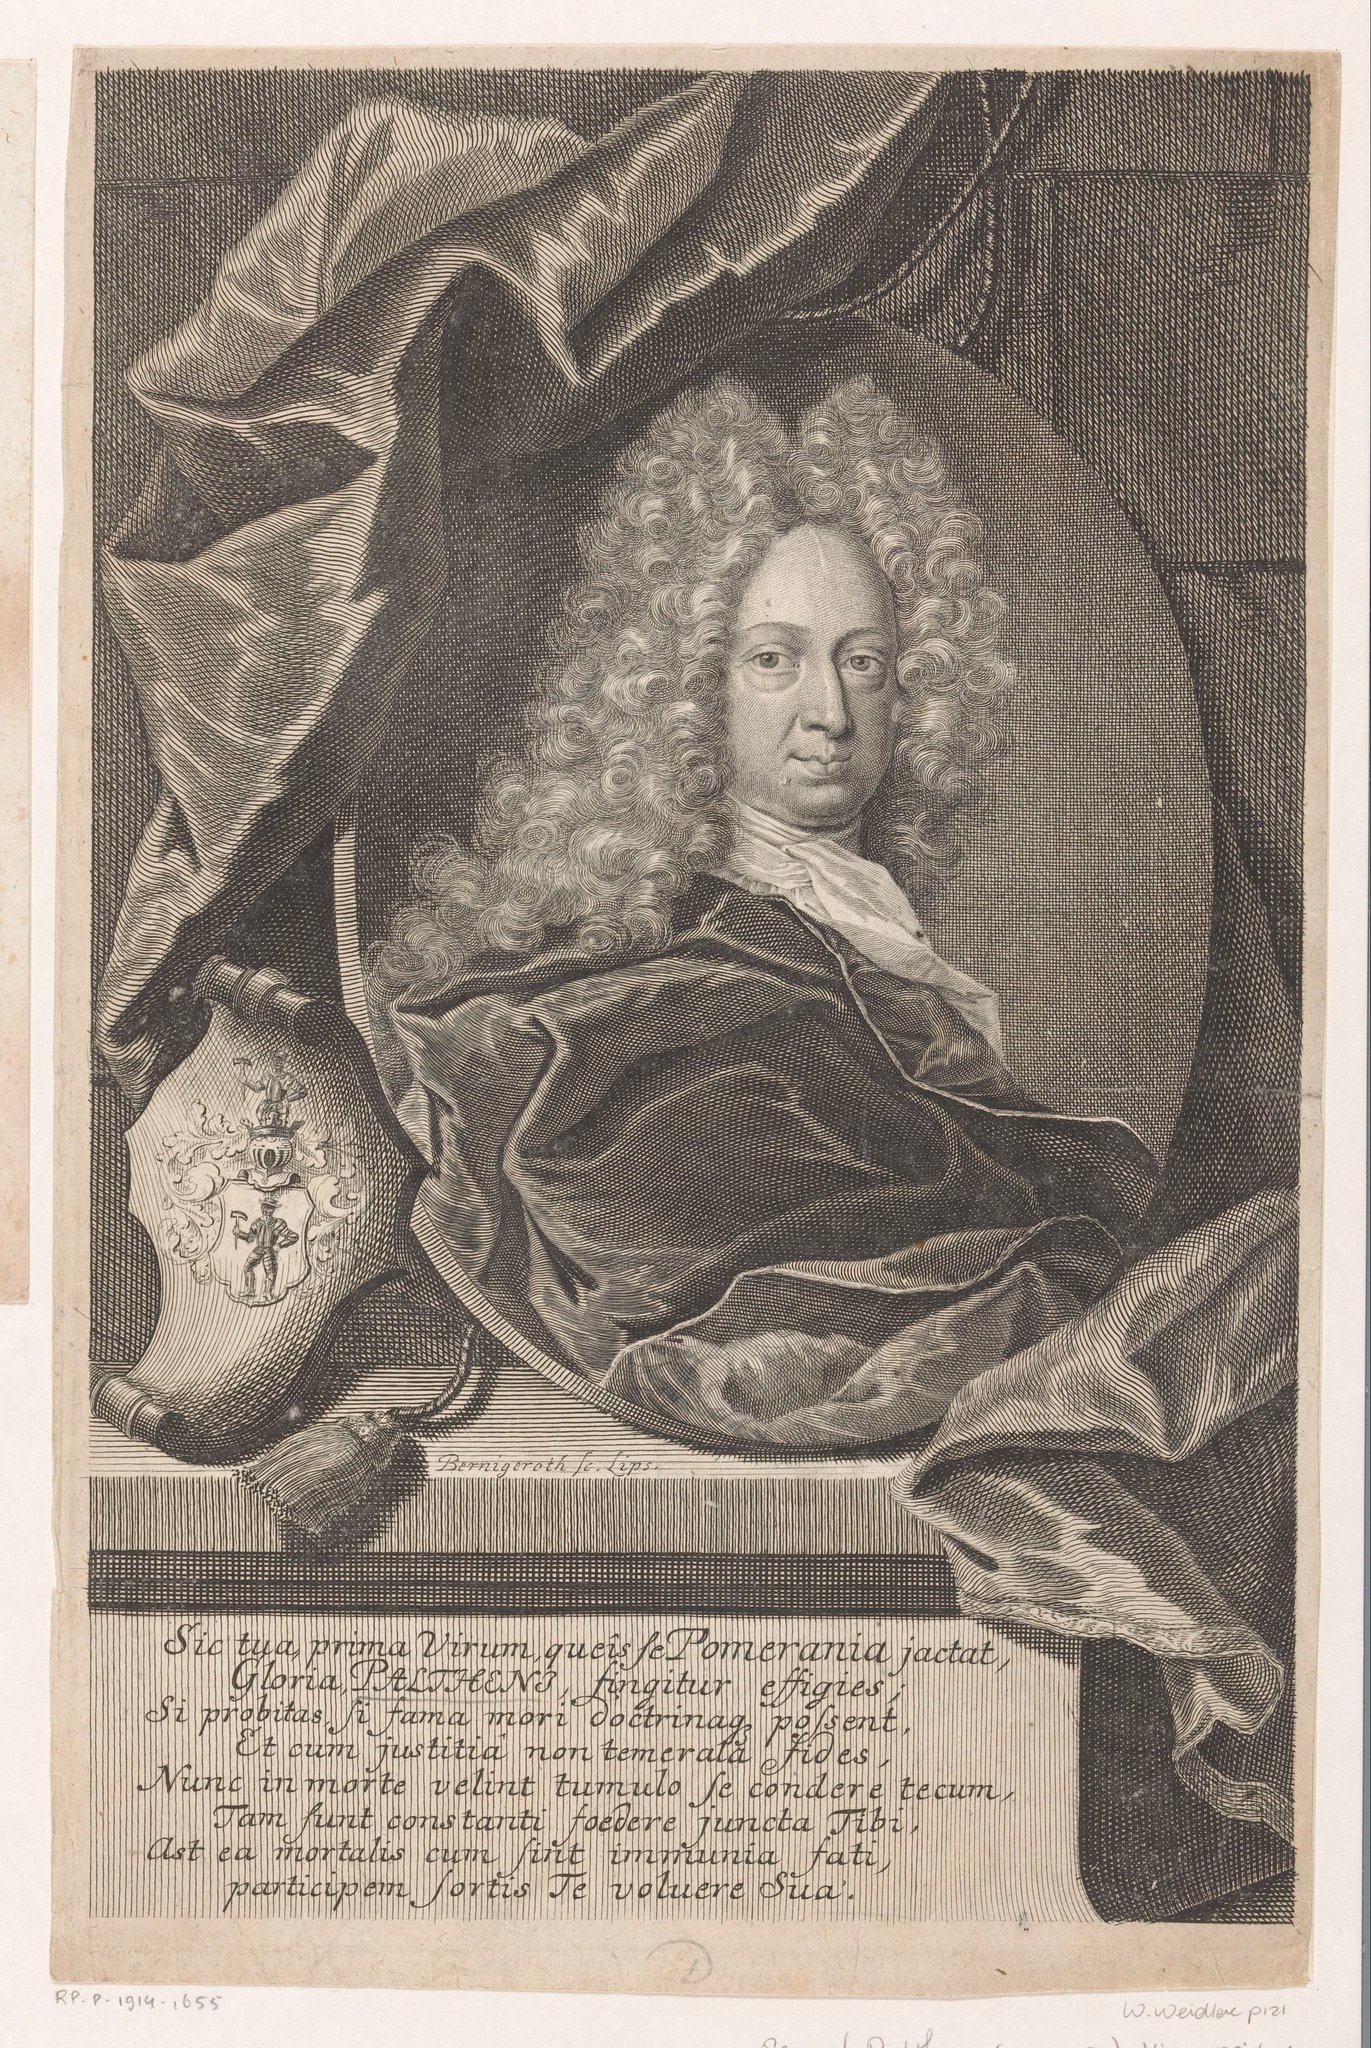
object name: print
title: Portret van Johann Philipp Palthen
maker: martin bernigeroth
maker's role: print maker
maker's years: 1670-1733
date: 1710-1733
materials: paper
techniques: engraving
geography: leipzig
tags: historical persons, armorial bearing, heraldry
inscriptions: collector's mark: Lugt 2228